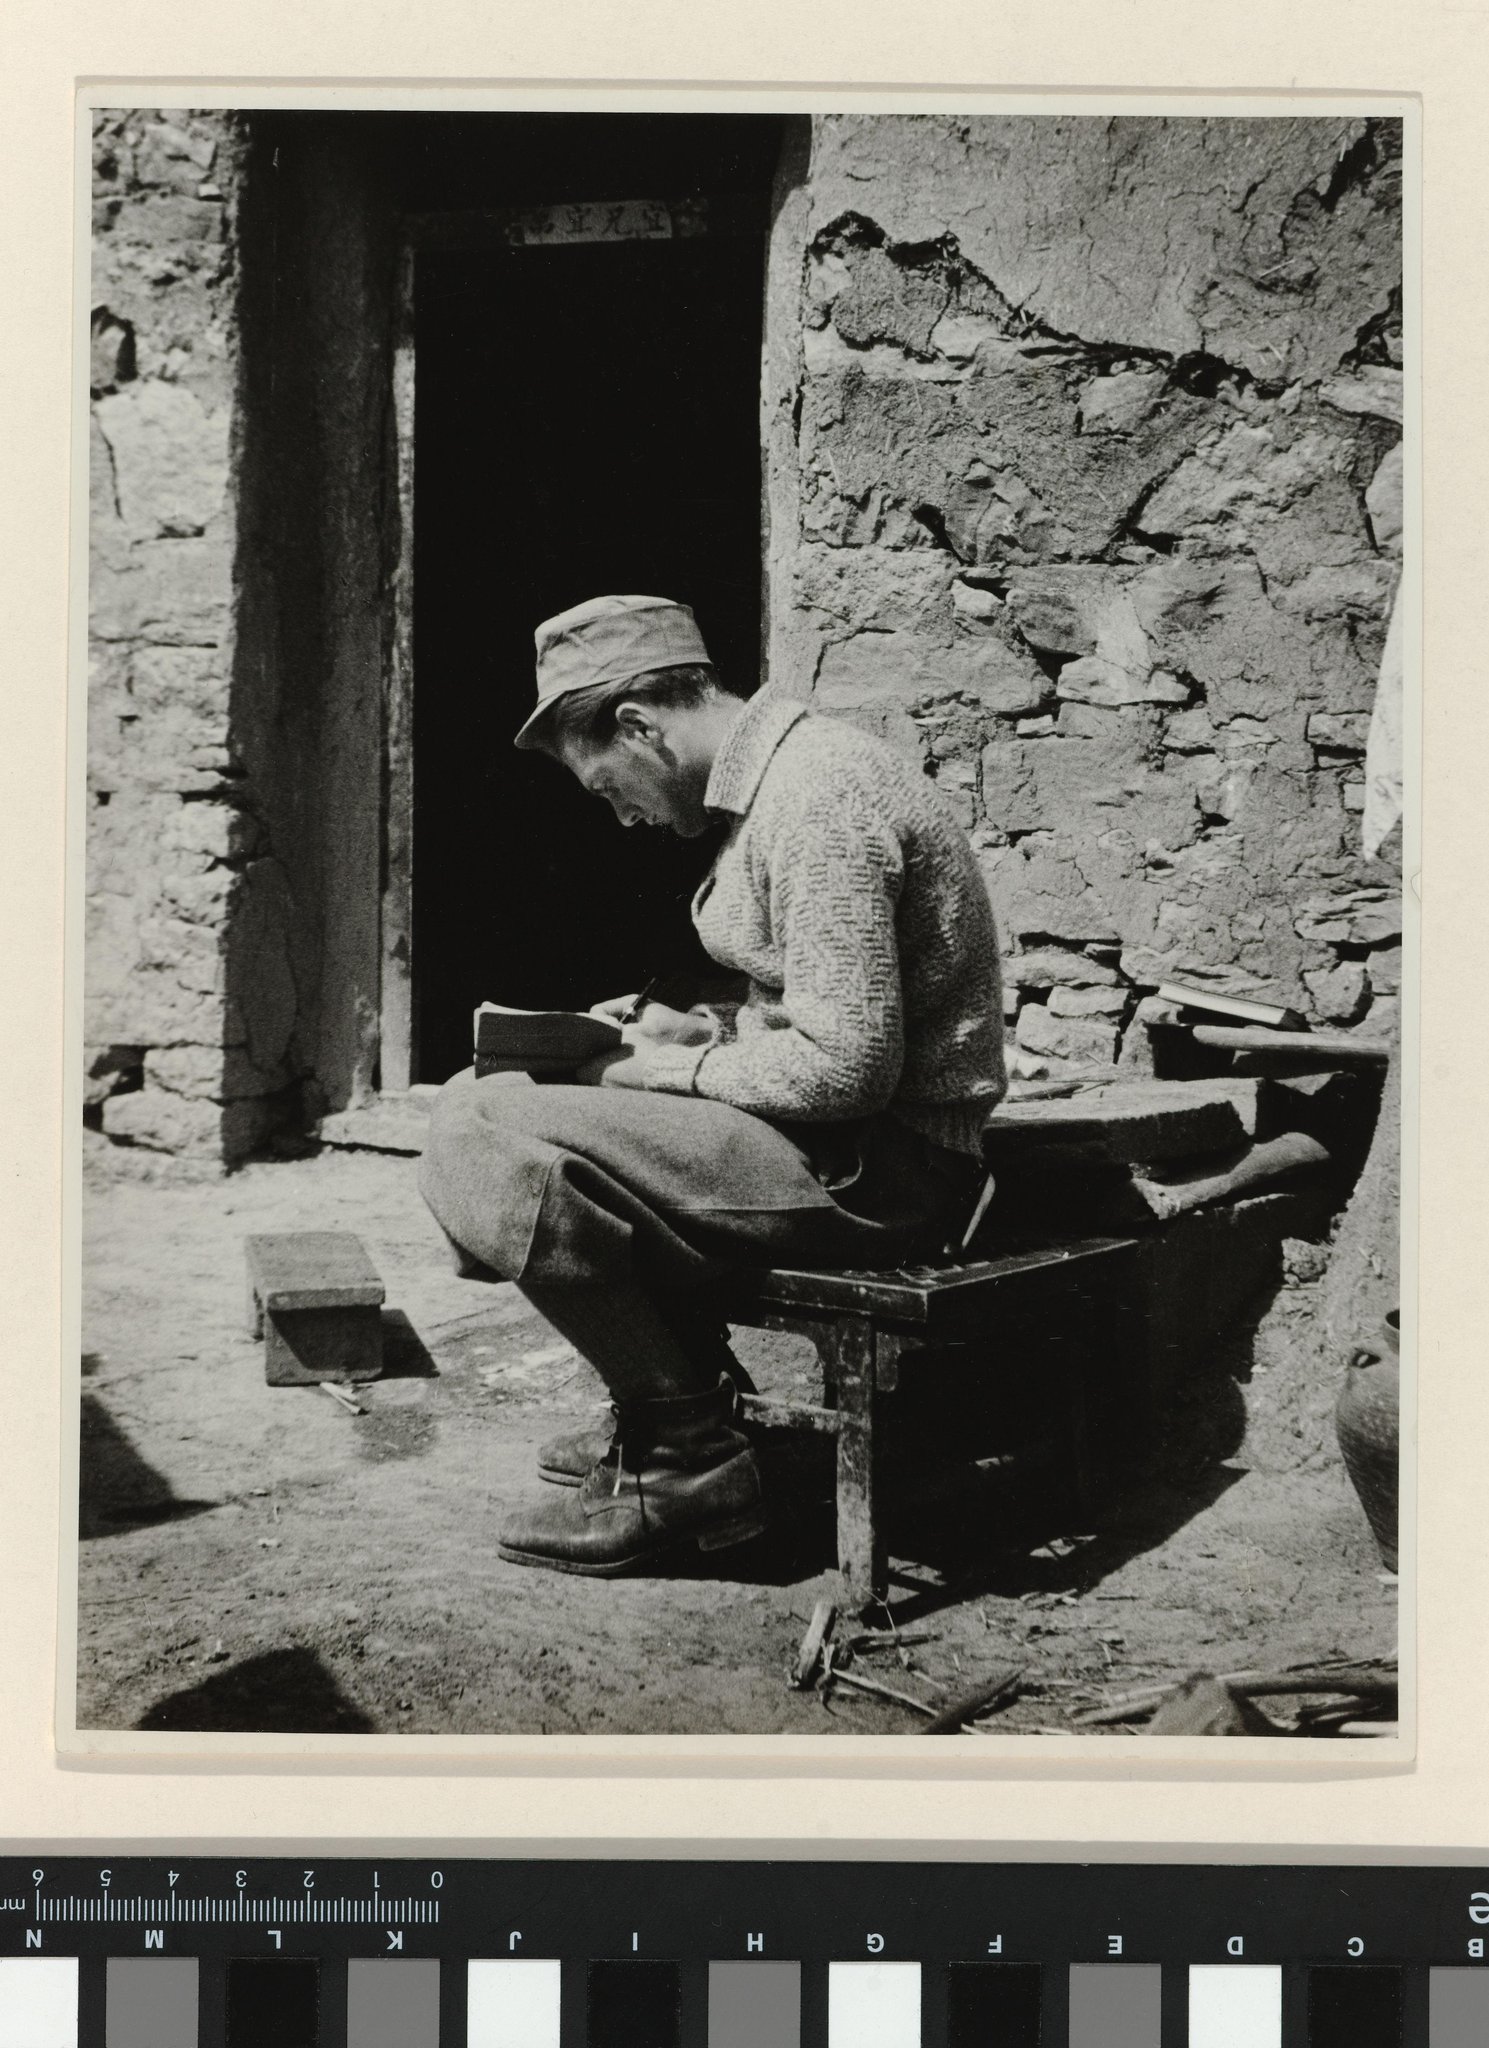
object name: photograph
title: John Fernhout schrijvend, China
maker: robert capa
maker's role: fotograaf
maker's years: 1913-1954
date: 1938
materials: paper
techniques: gelatin silver print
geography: china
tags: john fernhout, handwriting, writing as activity, china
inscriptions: annotation: ‘Fernhout/ by/ CAPA’, stamp: ‘B 518’